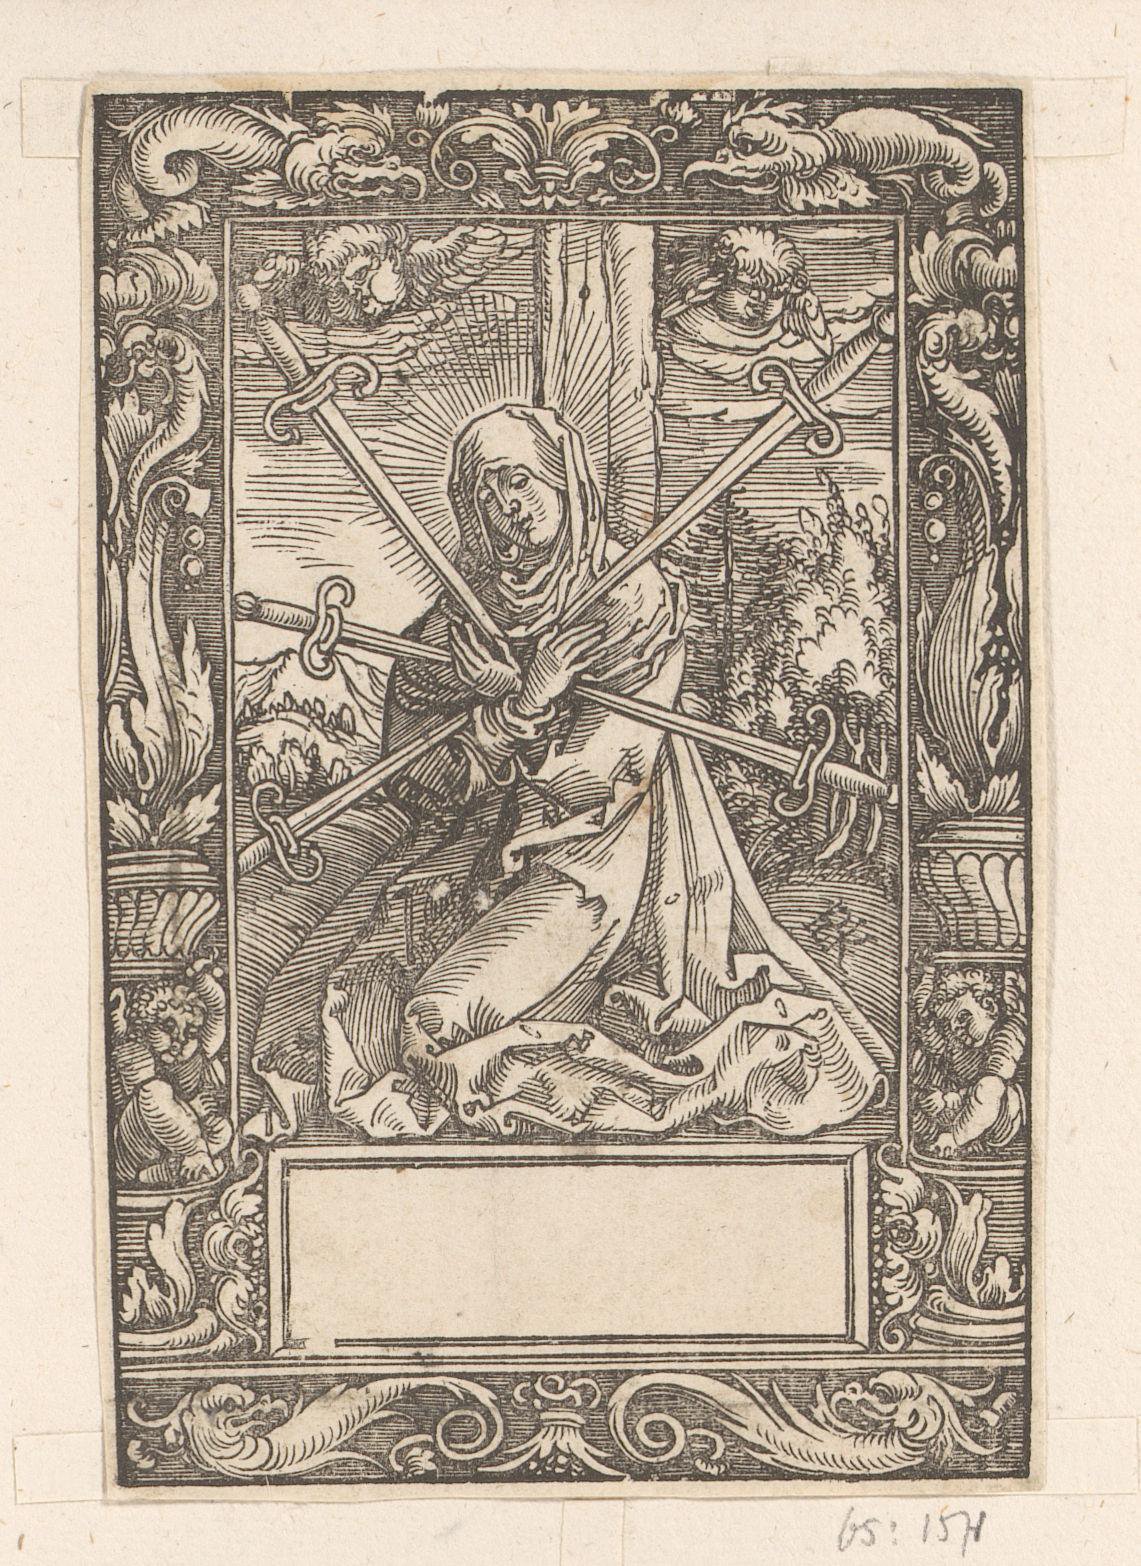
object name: book illustration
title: Maria als Mater Dolorosa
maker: hans springinklee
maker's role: print maker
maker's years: -1540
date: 1518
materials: paper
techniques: woodcut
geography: nuremberg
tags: mary pierced by a sword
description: Maria als Mater Dolorosa. Haar hart wordt doorboord met vijf zwaarden, terwijl ze onder het kruis zit. De voorstelling is gevat in een ornamenteel kader. Prent maakt deel uit van een album.